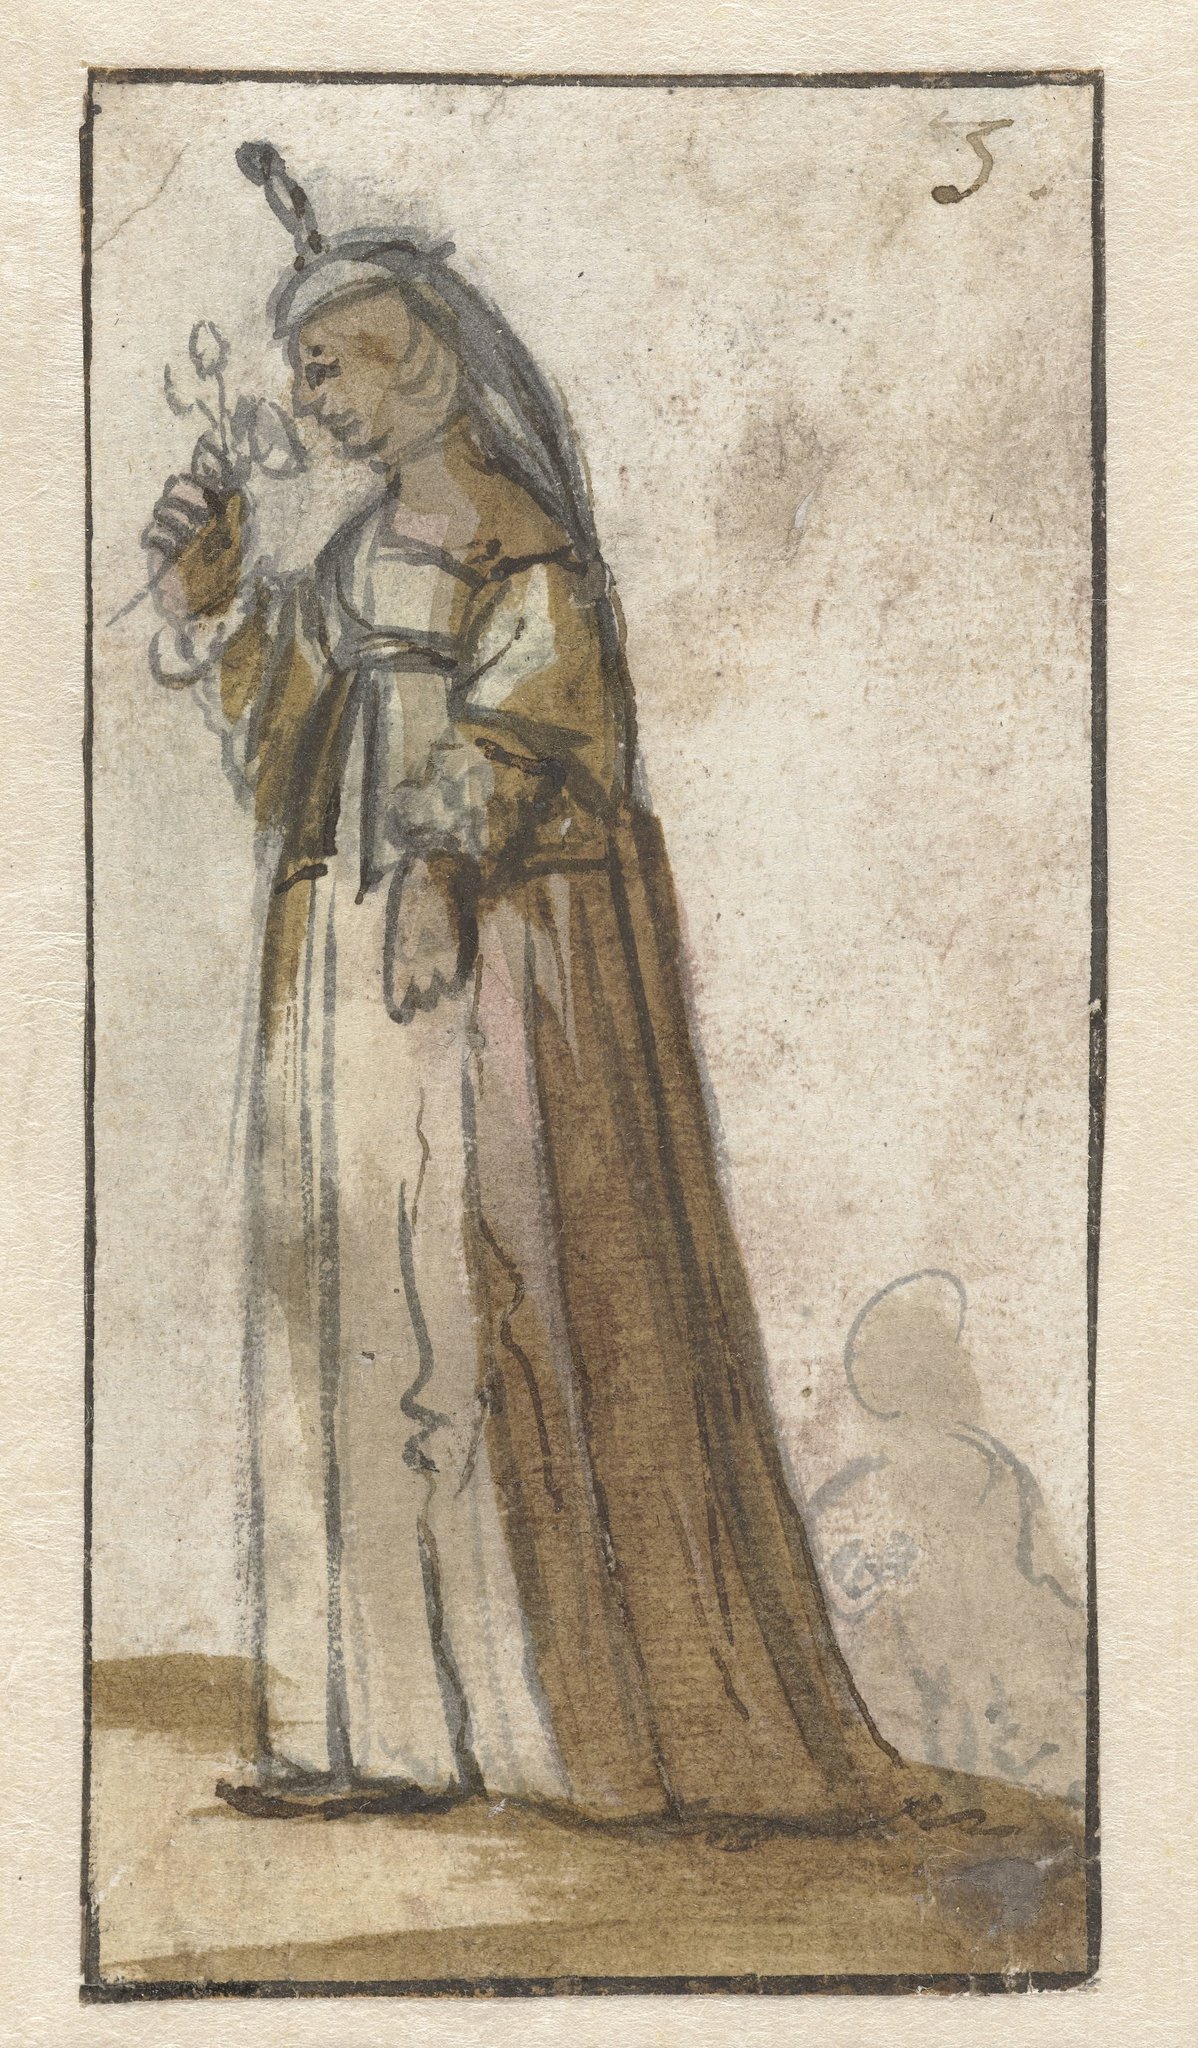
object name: drawing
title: De vijf zintuigen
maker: Anonymous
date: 1600-1699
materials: chalk, paper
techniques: brush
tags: flowers, adult woman, smell, smelling (one of the five senses)